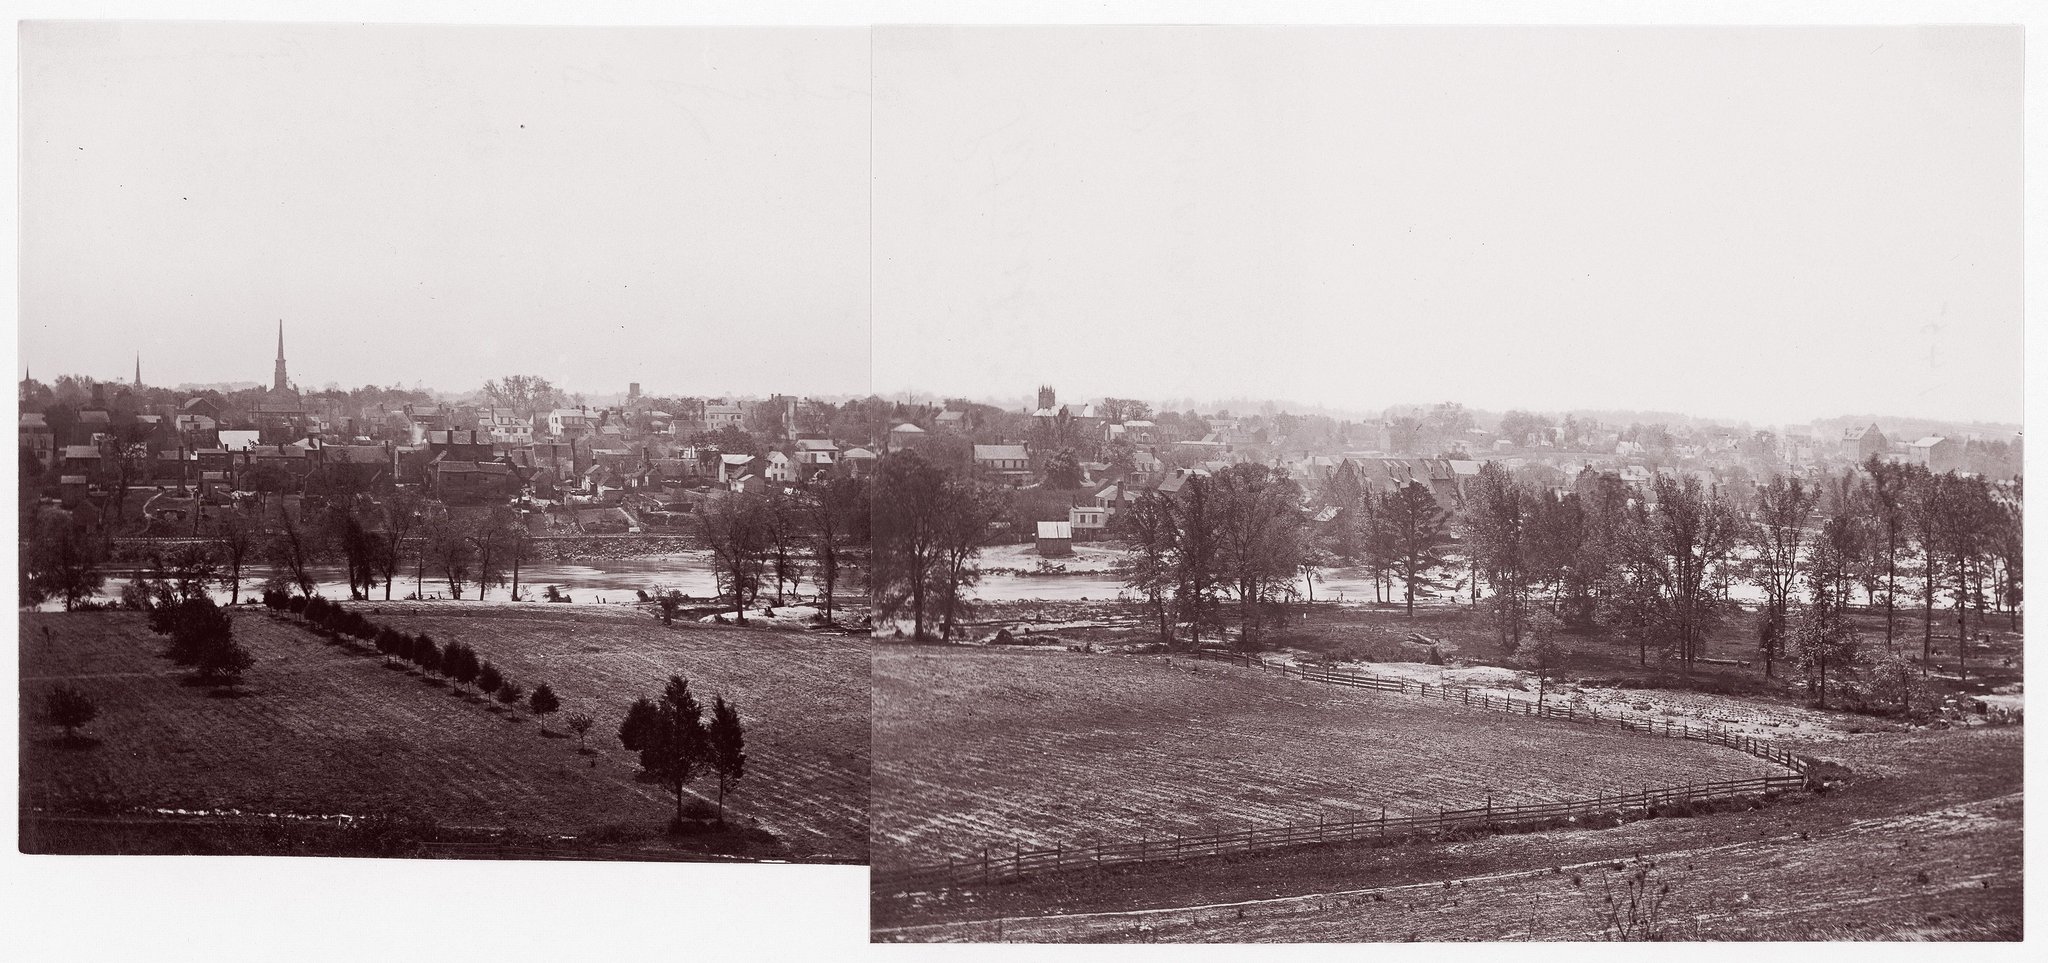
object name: photograph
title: [Petersburg, Virginia]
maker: alexander gardner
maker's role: artist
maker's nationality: american, scottish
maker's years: 1821-1882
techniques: albumen silver print, glass negative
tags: american civil war,landscapes